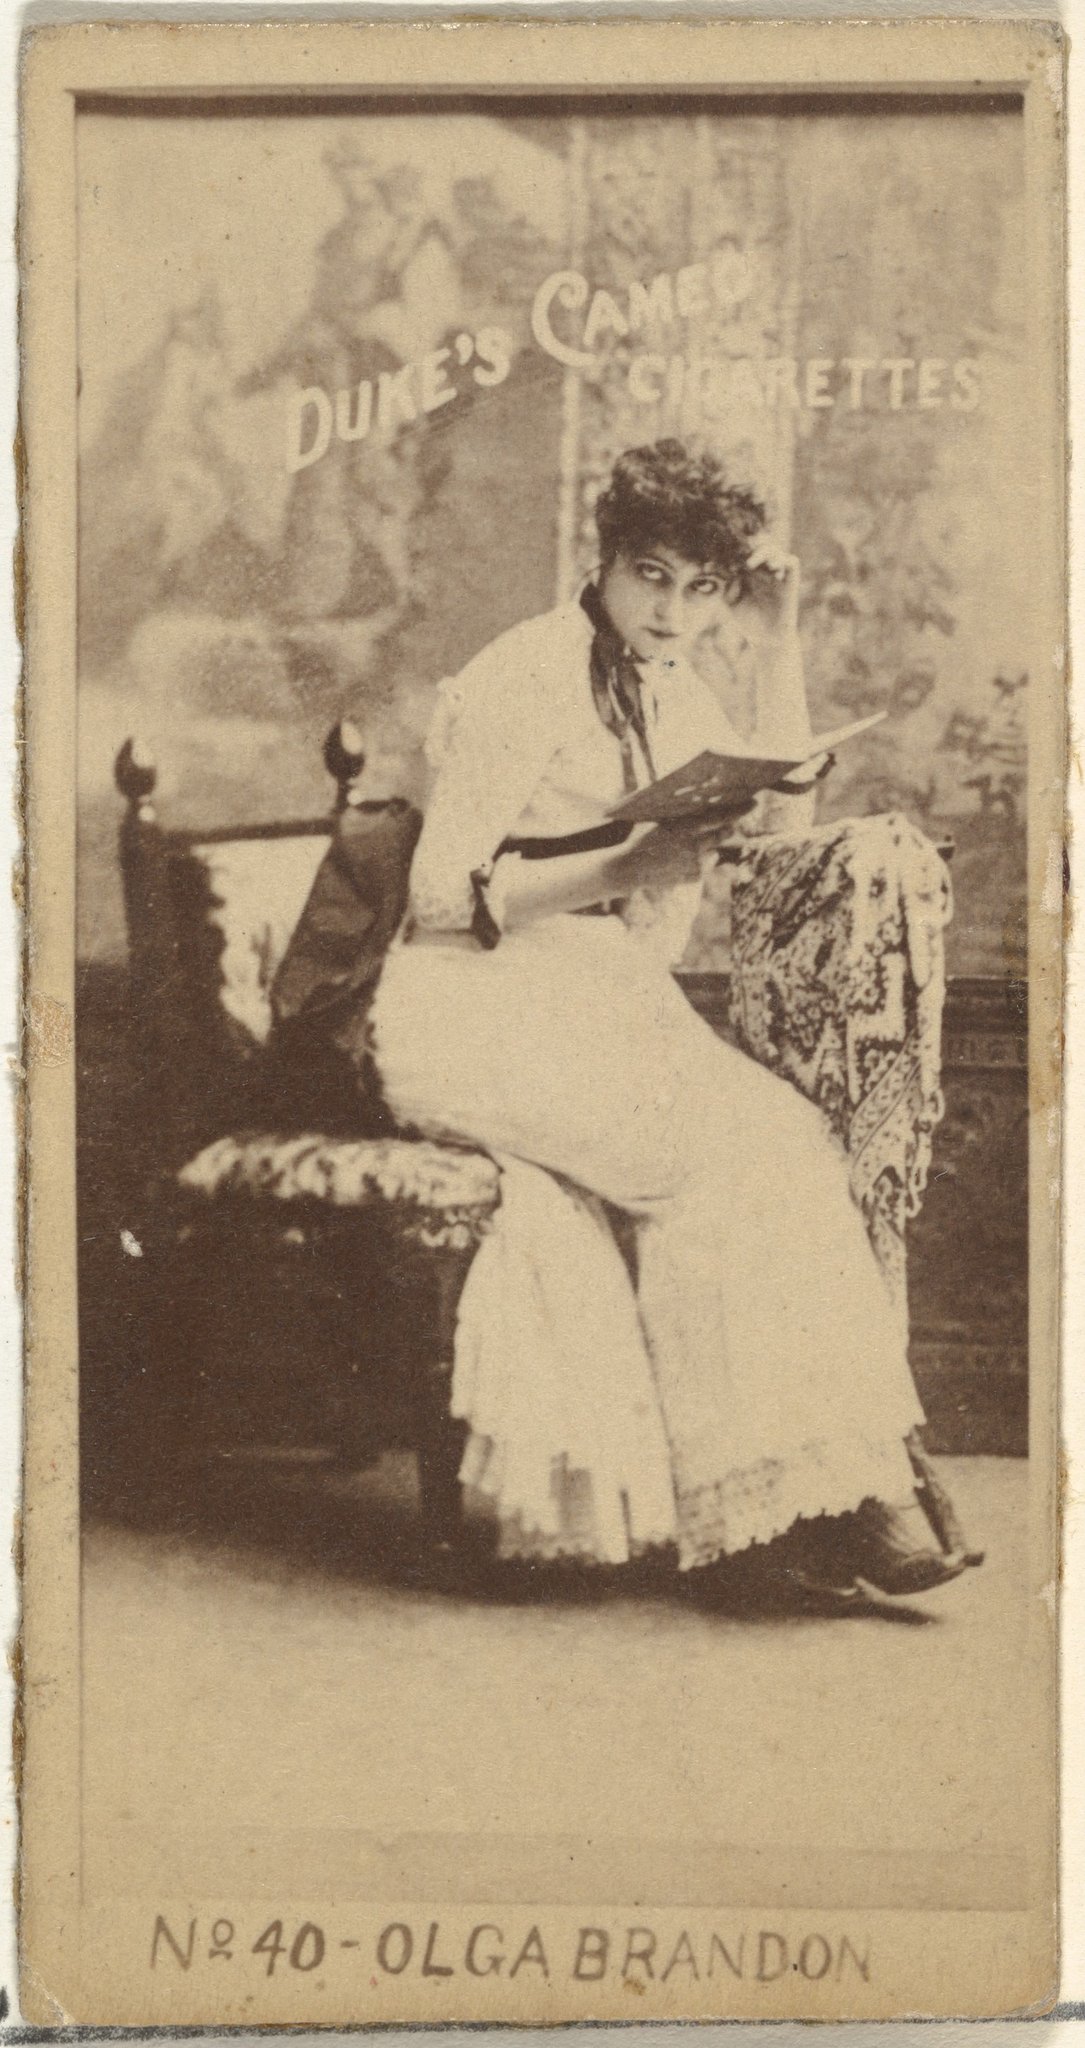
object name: photograph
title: Card Number 40, Olga Brandon, from the Actors and Actresses series (N145-4) issued by Duke Sons & Co. to promote Cameo Cigarettes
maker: w. duke, sons & co.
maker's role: publisher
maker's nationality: american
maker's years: 1870-1920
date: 1880-1889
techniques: albumen silver print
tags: portraits,women,actresses